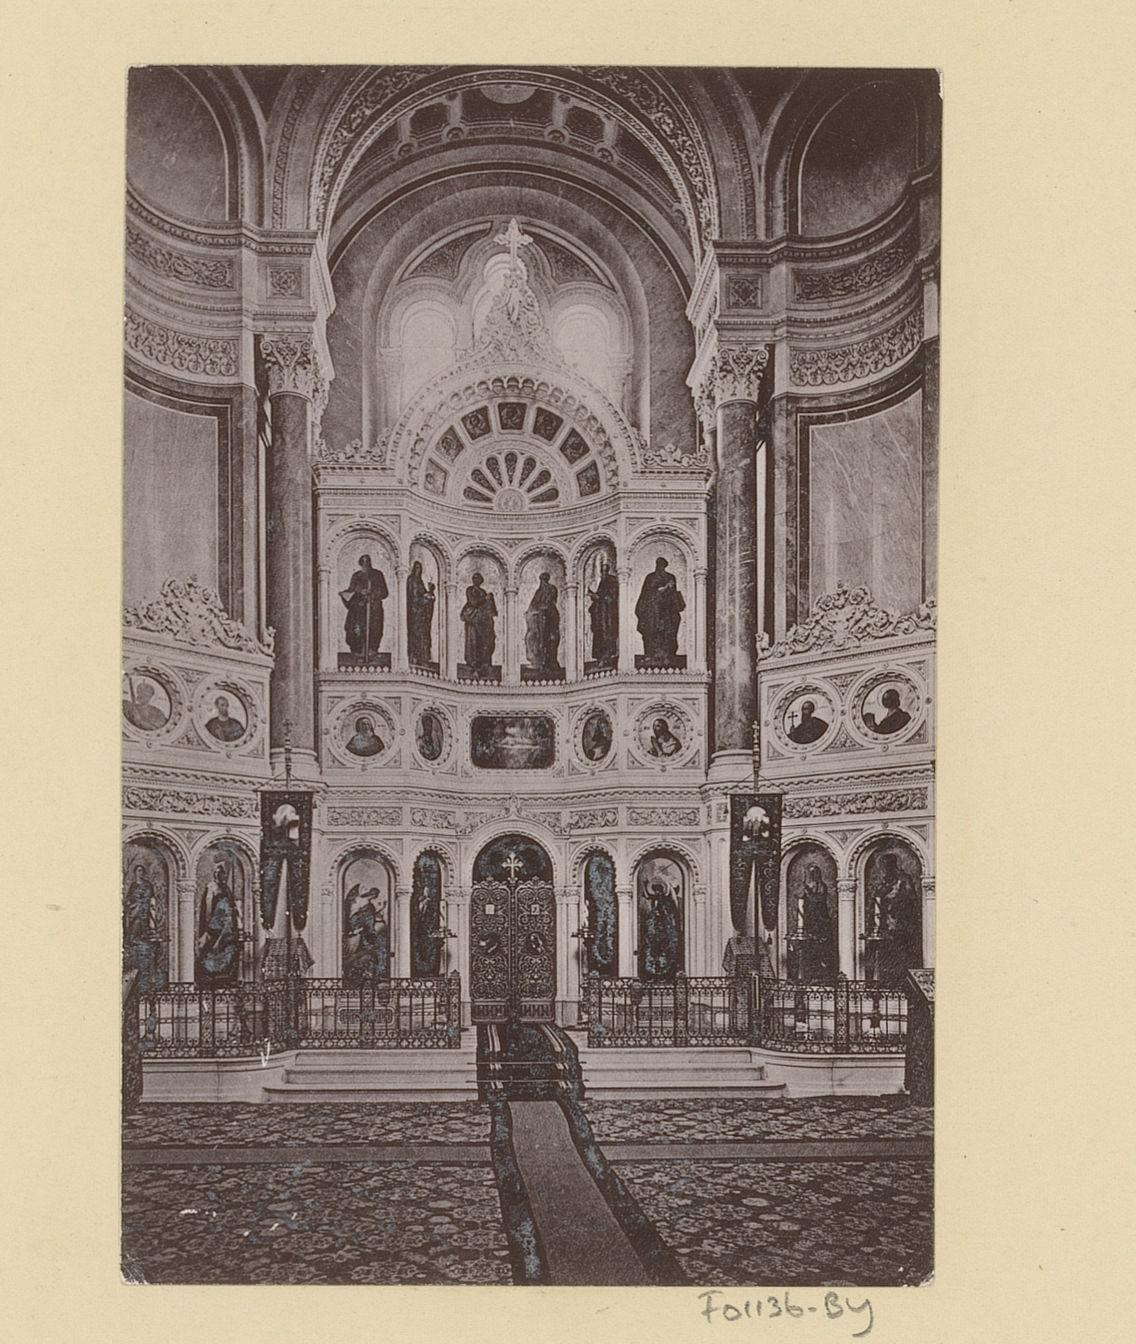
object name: photomechanical print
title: Interieur van de Russische kerk van de Heilige Elisabeth in Wiesbaden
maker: Anonymous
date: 1880-1895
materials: paper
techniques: photograph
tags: parts of church interior: choir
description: Onderdeel van Fotoalbum met opnames van bezienswaardigheden in België, Duitsland en Noorwegen.